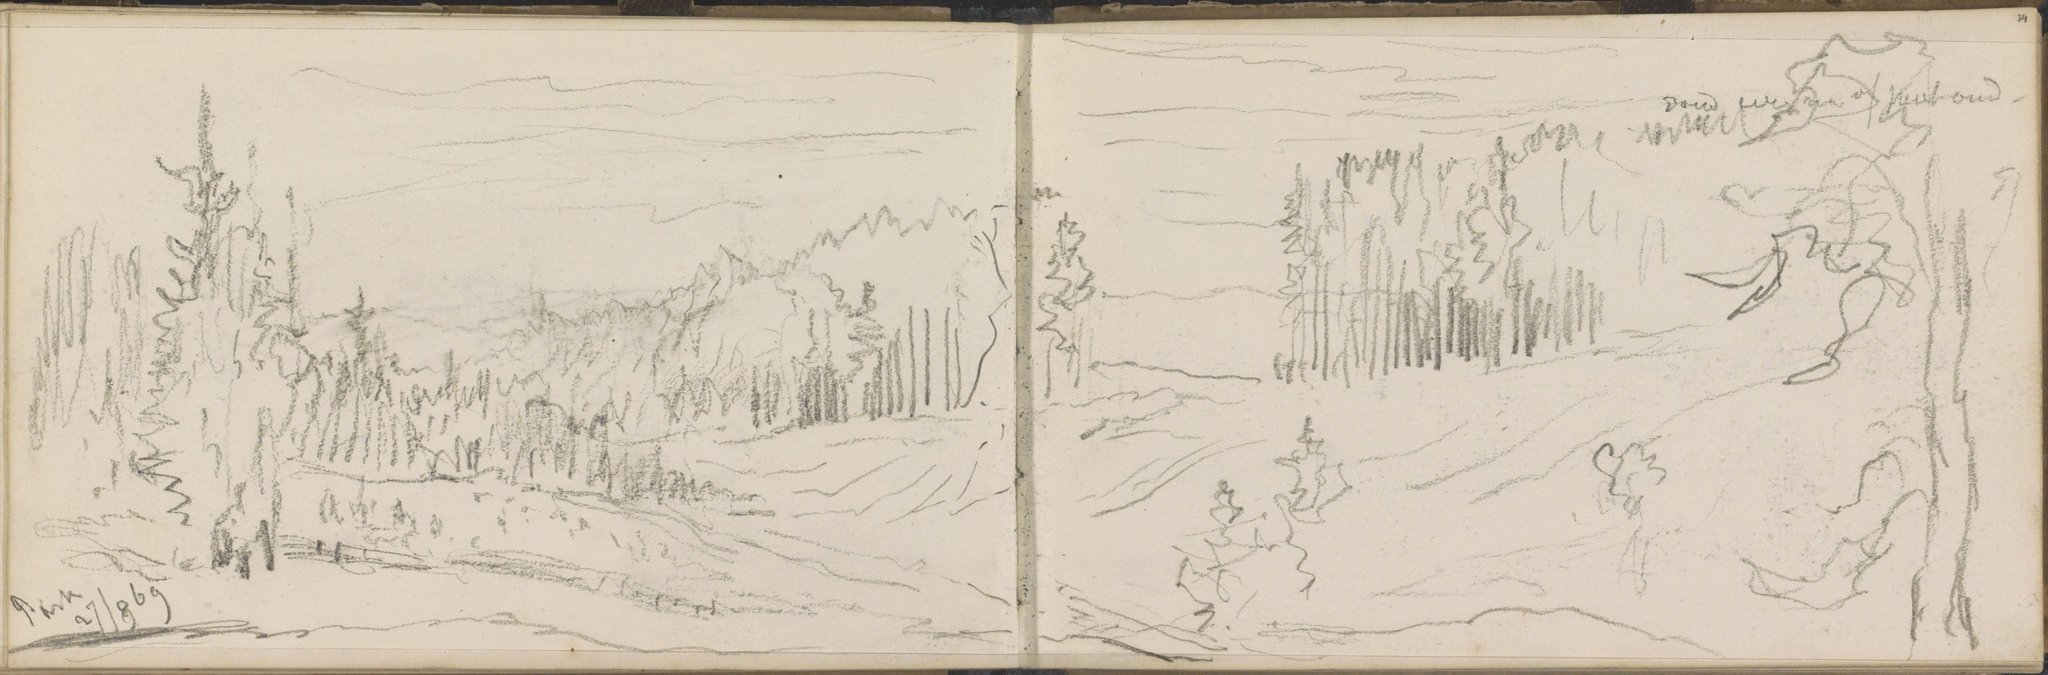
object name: sketchbook leaf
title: Park van Metternich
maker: johannes tavenraat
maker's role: draughtsman, painter, print maker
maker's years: 1809-1881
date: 1808-1869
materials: paper, pencil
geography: marienbad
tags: landscapes, marienbad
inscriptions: date and inscription: ‘Park/ 27/8 69’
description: Blad 33 verso en 34 recto uit een schetsboek met 48 bladen.